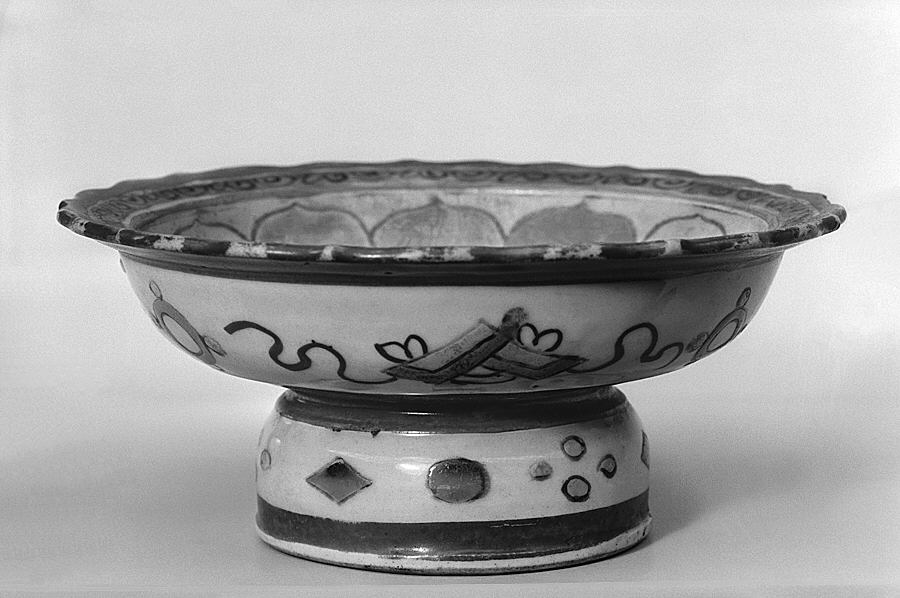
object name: dish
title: Foliated dish with lotus design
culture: chinese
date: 1801-1900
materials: enamel, porcelain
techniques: overglaze, painting, polychrome